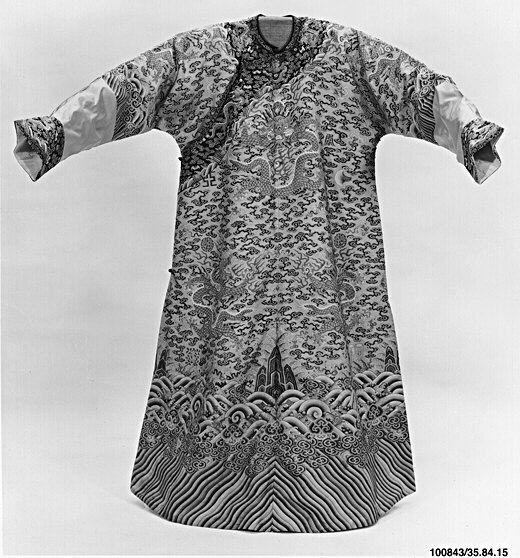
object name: robe, emperor's 12 symbol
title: Emperor's Twelve-Symbol Robe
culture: chinese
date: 1723-1735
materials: metal thread, silk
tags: dragons